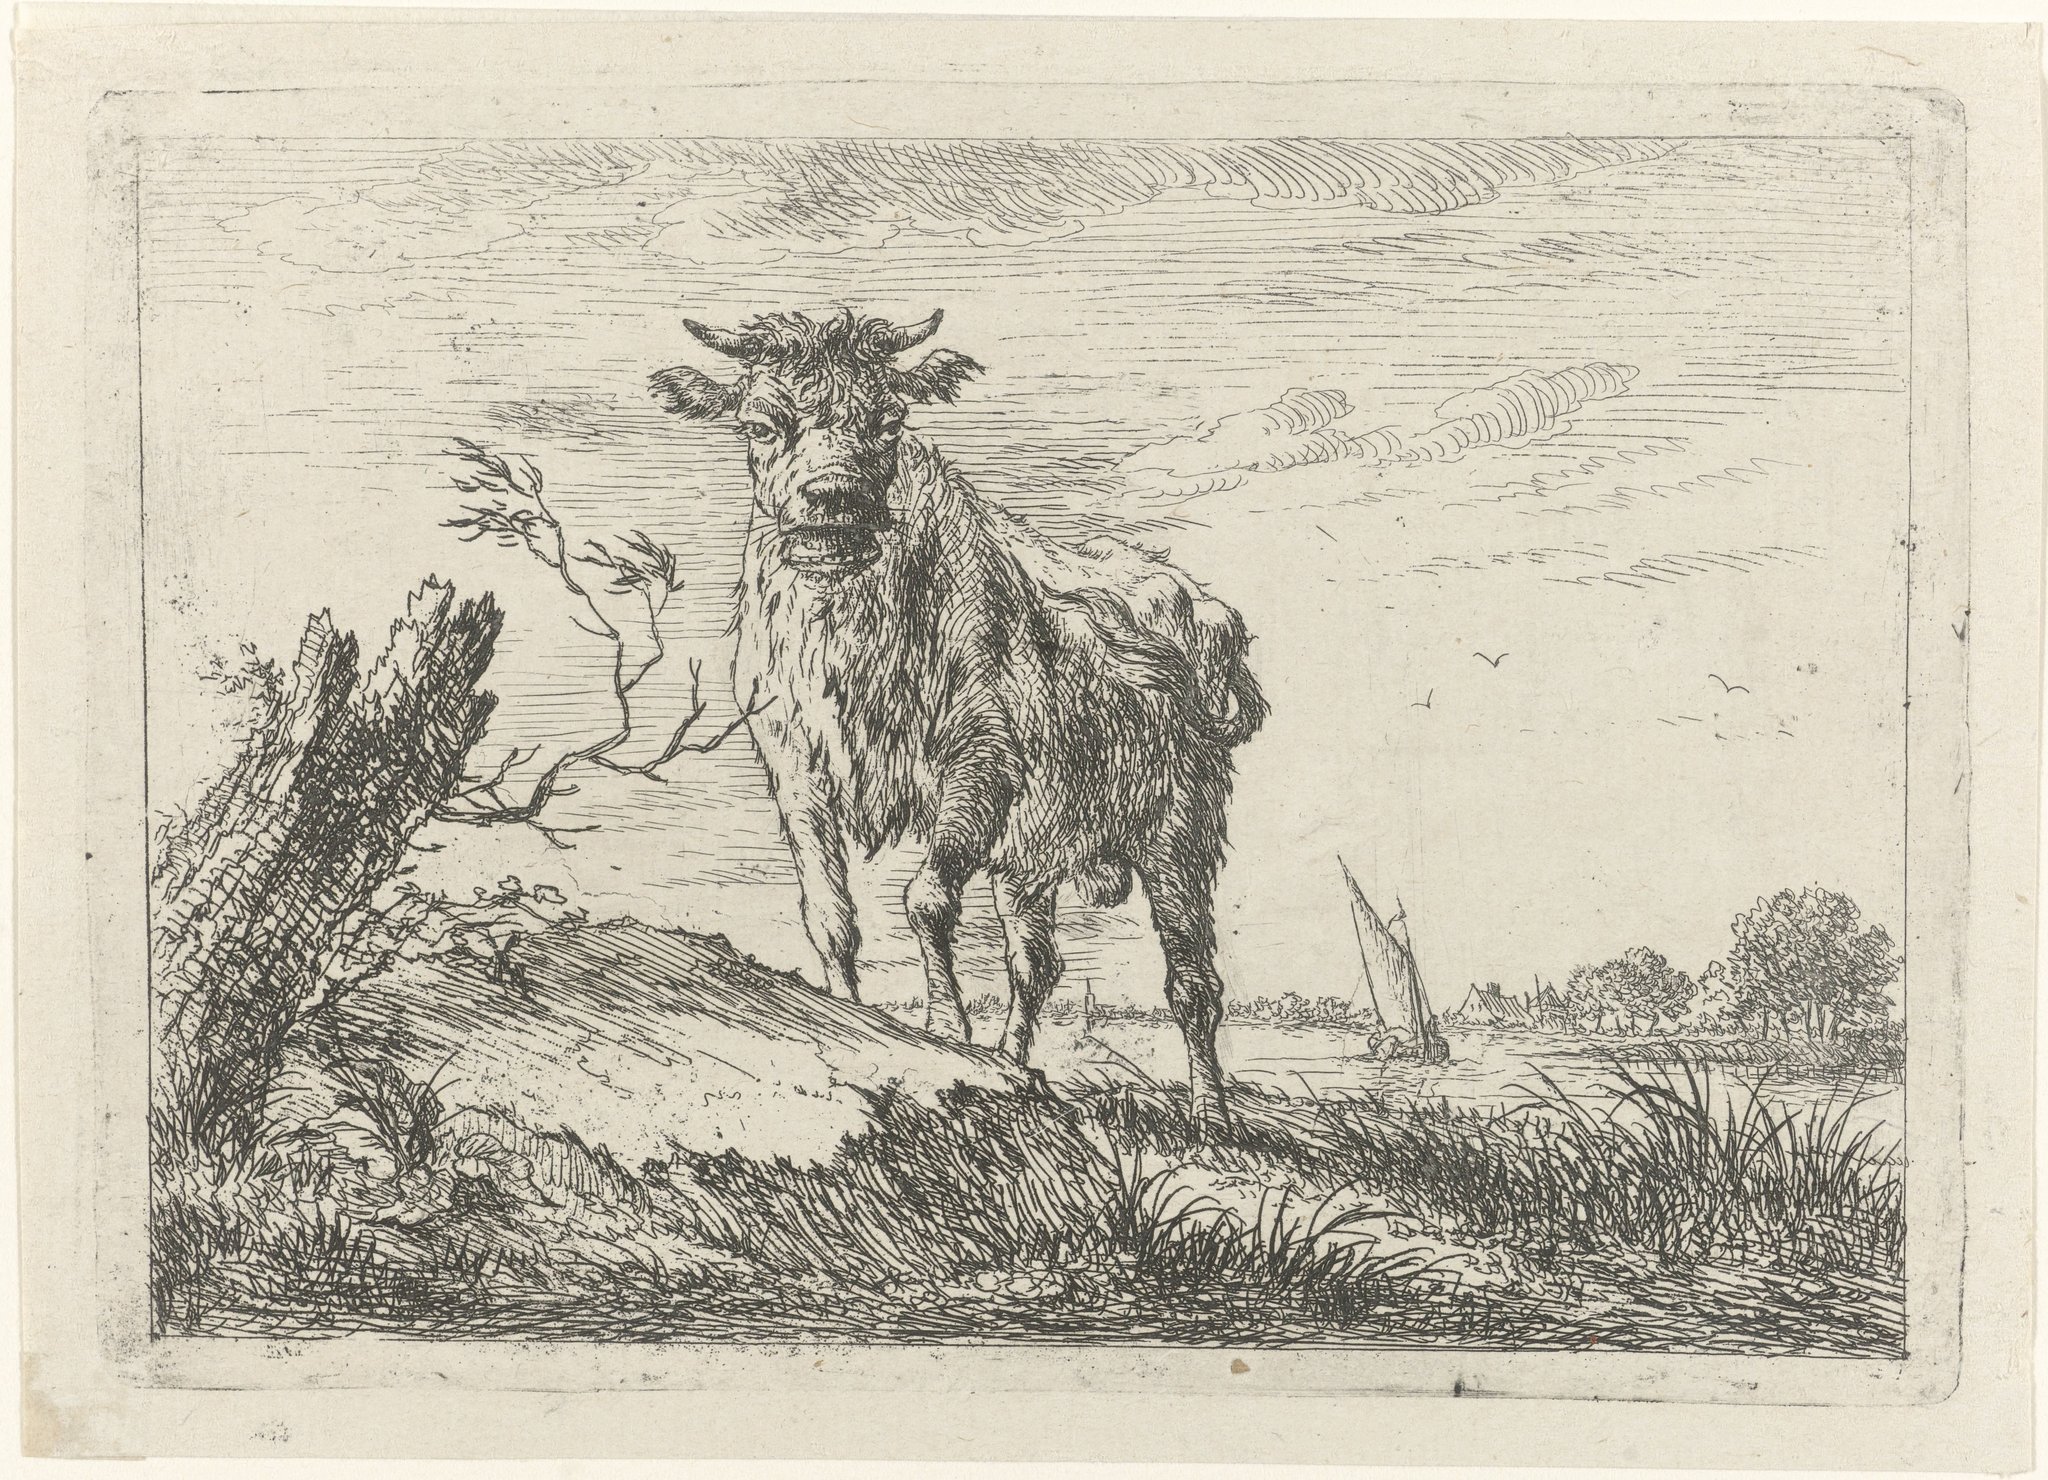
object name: print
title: Stier aan rivieroever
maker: johannes janson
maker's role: draughtsman, painter, print maker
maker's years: 1729-1784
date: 1761-1784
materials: paper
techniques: etching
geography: leiden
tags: bull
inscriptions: collector's mark: Lugt 240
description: Een brullende stier aan de oever van een rivier, links een boomstronk. Prent uit een serie met landschappen met vee.